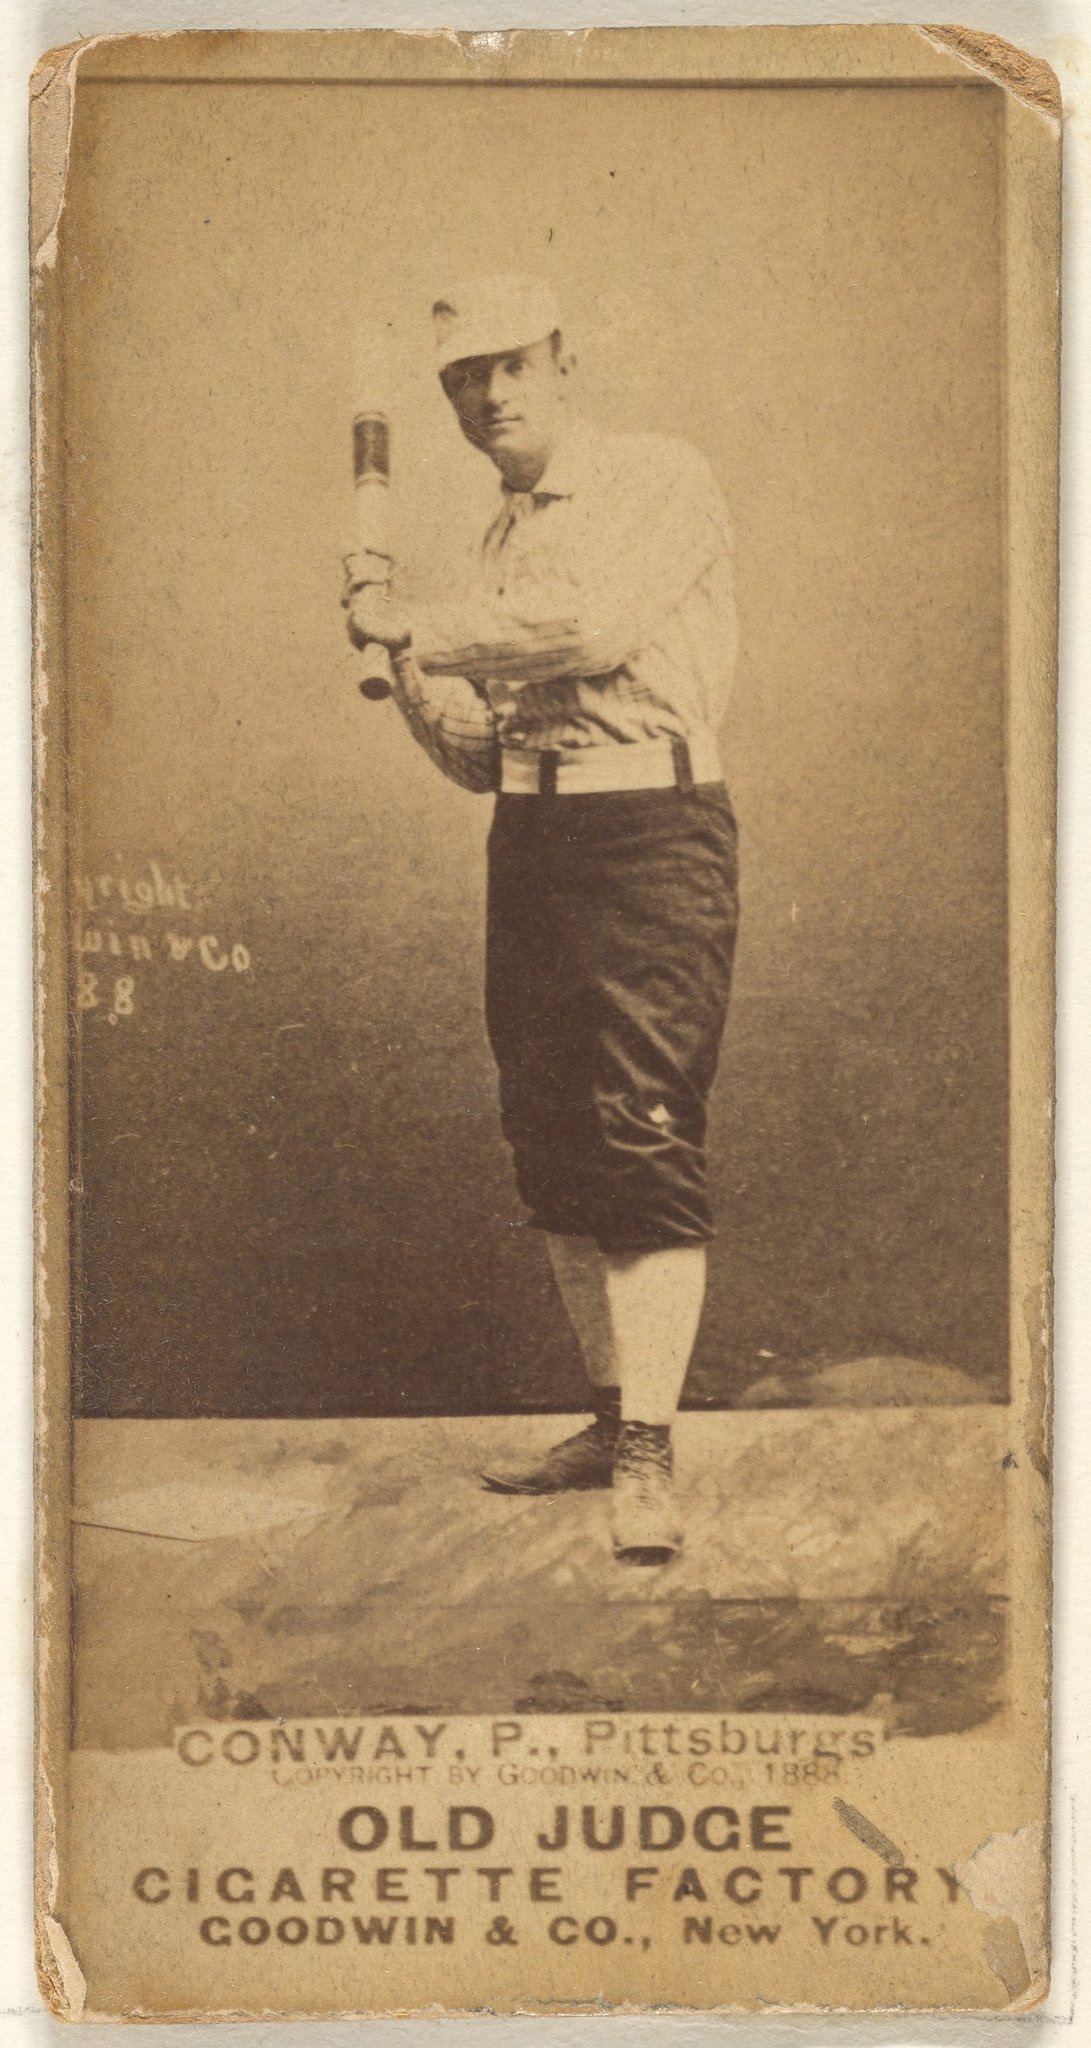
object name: baseball card, photograph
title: Pete Conway, Pitcher, Pittsburgh, from the Old Judge series (N172) for Old Judge Cigarettes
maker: goodwin & company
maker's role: publisher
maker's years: 1850-1950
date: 1888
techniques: albumen silver print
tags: men,portraits,baseball,athletes